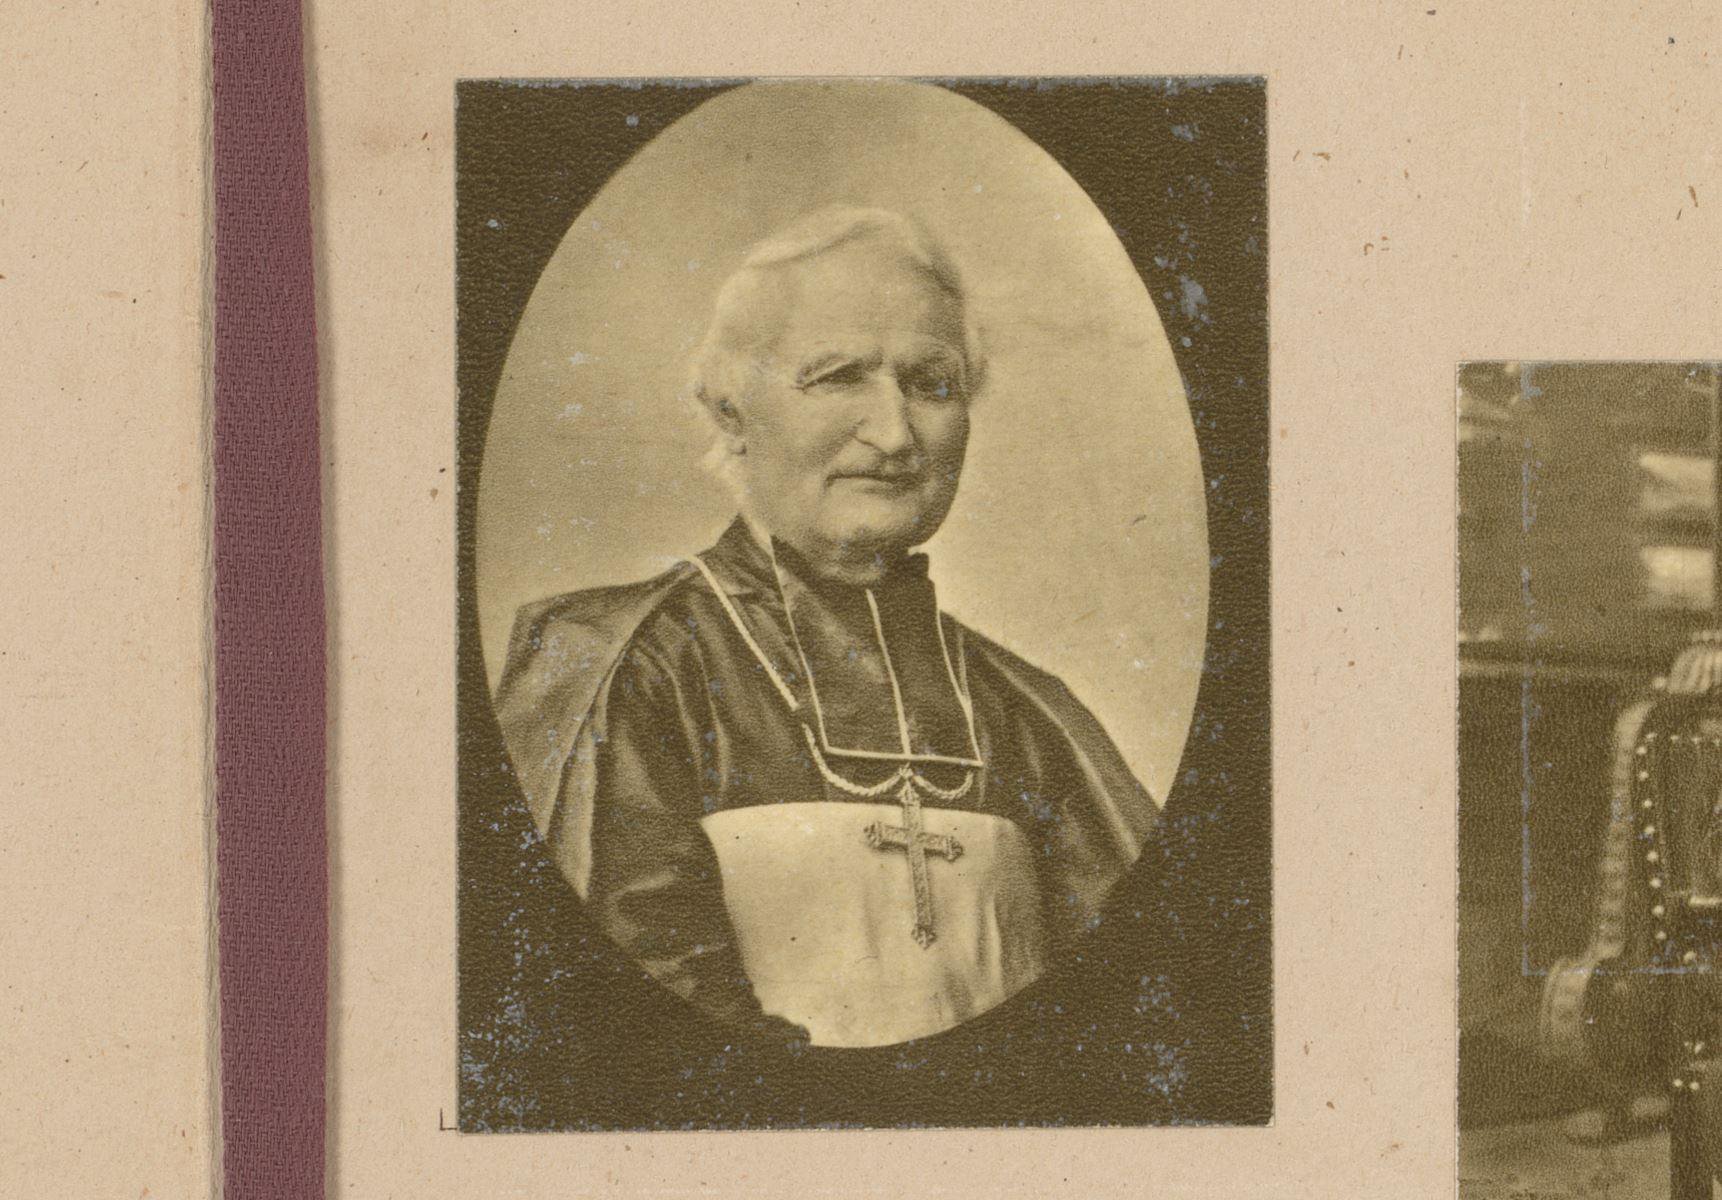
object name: album leaf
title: Portret van Félix Dupanloup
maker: françois marie louis franck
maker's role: fotograaf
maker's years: 1816-1906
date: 1900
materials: paper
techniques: rotogravure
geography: france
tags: priest, politician, historical persons, organization, functionaries and dignitaries in roman catholic church; clergy in general, france